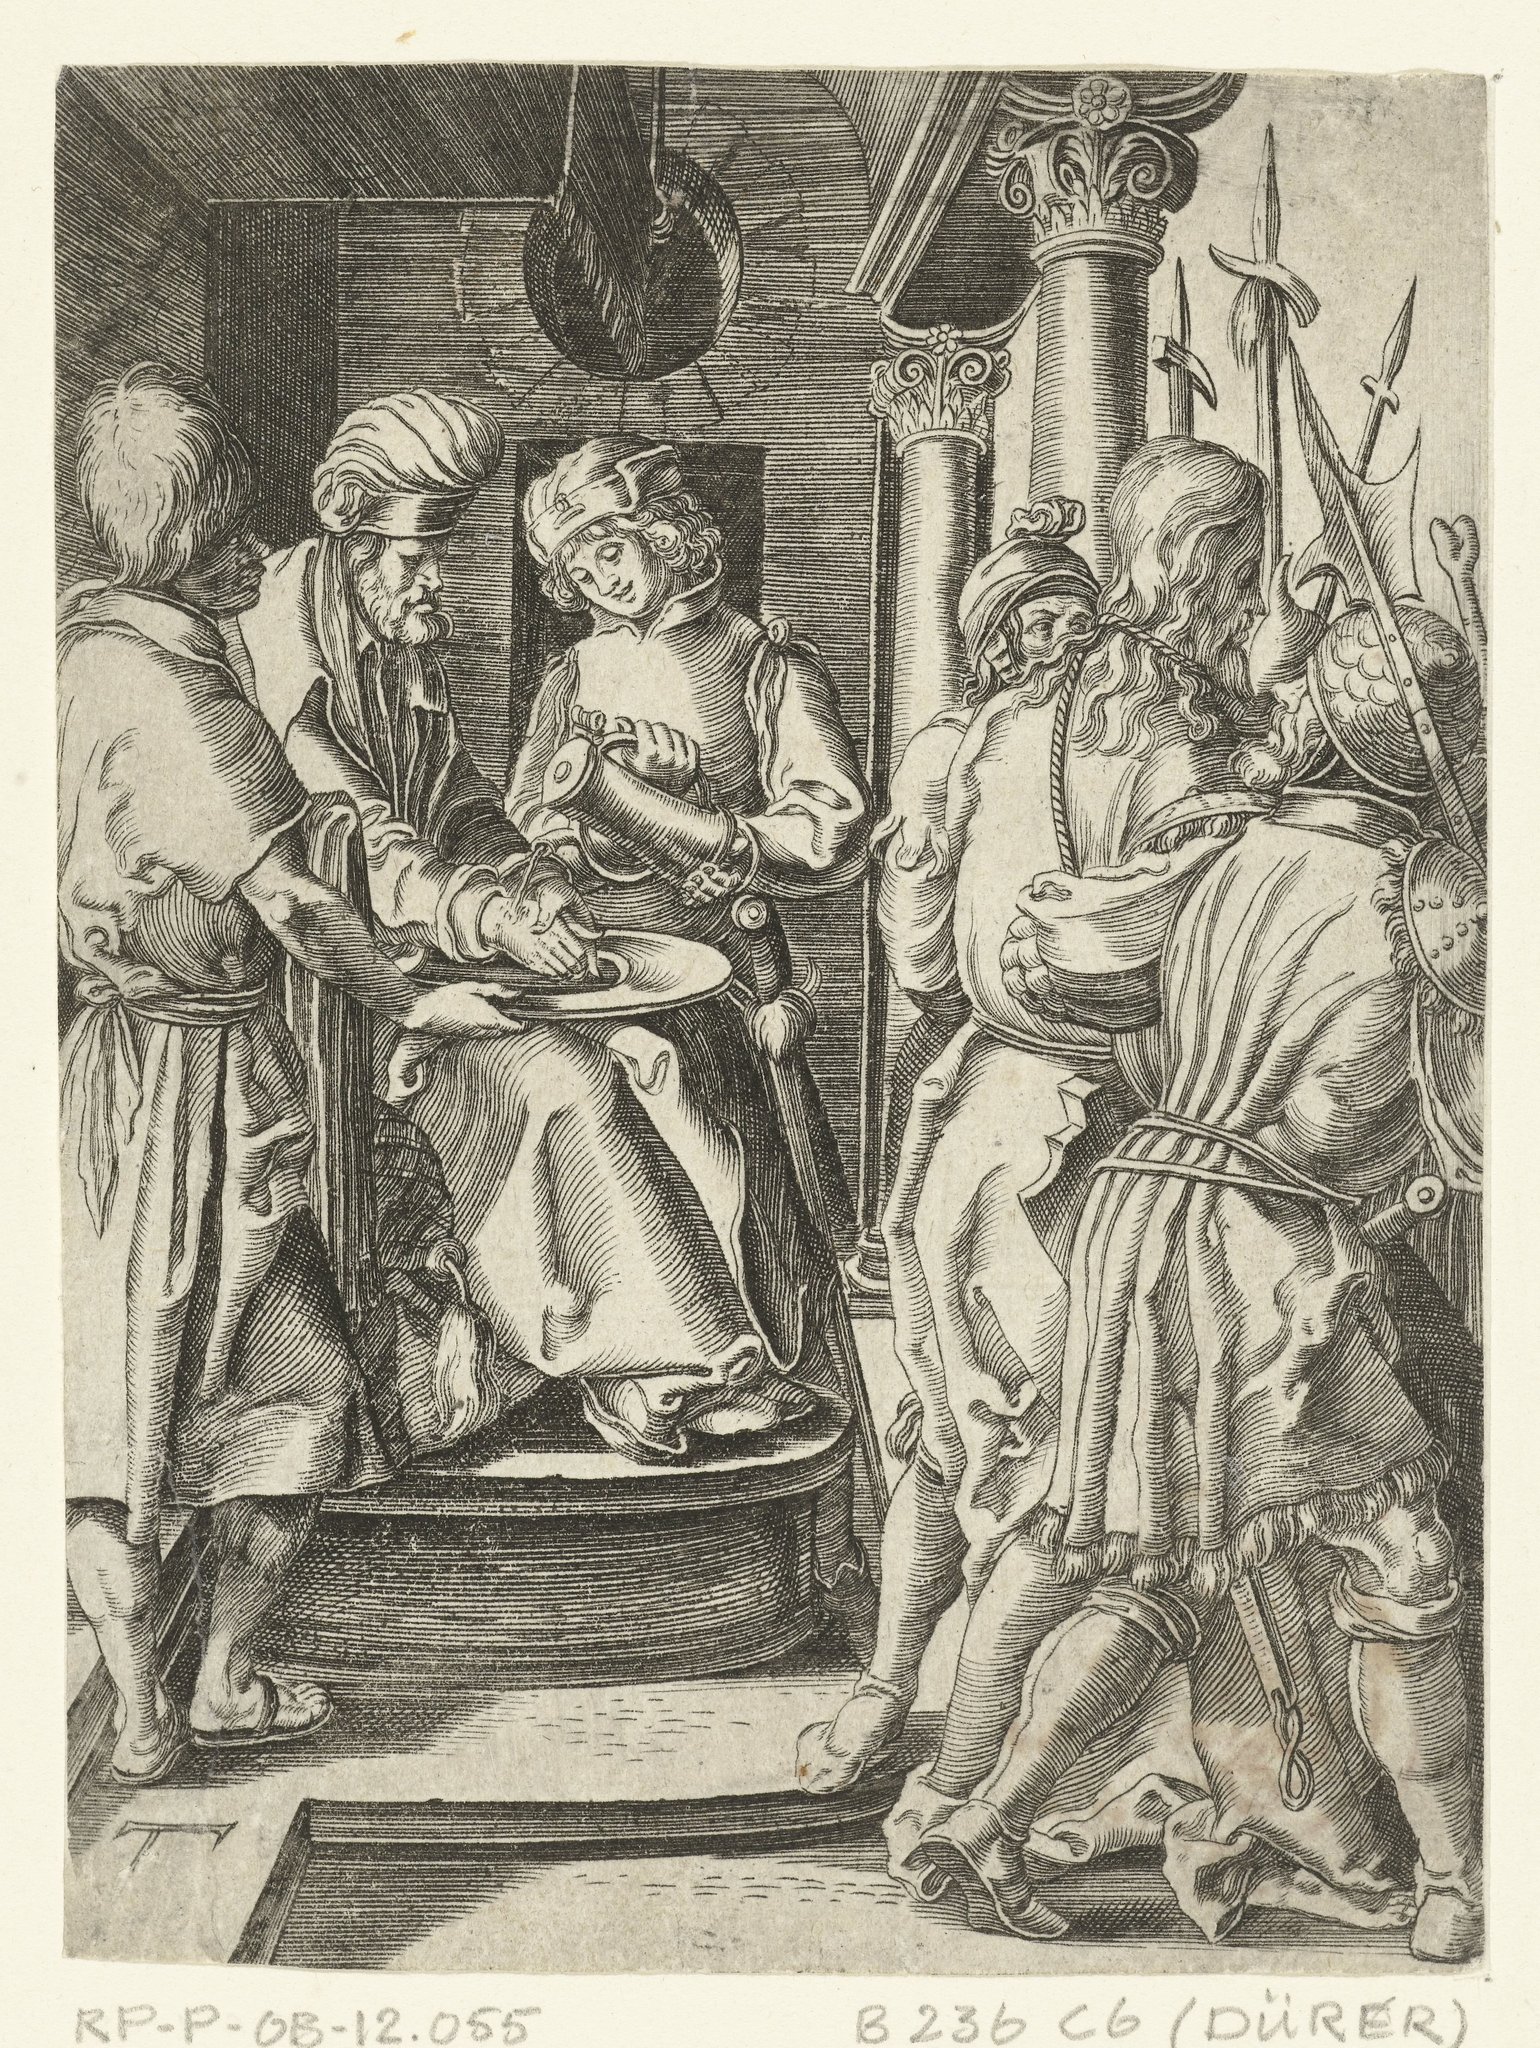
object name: print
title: Passie van Christus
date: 1510-1699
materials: paper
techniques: engraving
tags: pilate washing his hands (in innocence)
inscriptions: collector's mark: Lugt 12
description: Prent naar houtsnede van Albrecht Dürer uit een serie van zevenendertig prenten met als onderwerp het levensverhaal van Christus, bekend als Passie van Christus. Illustratie gebruikt voor: Passio Christi ab Alberto Durer Nurenburgensi effigiata, Abraham van Waesberge (uitgever).